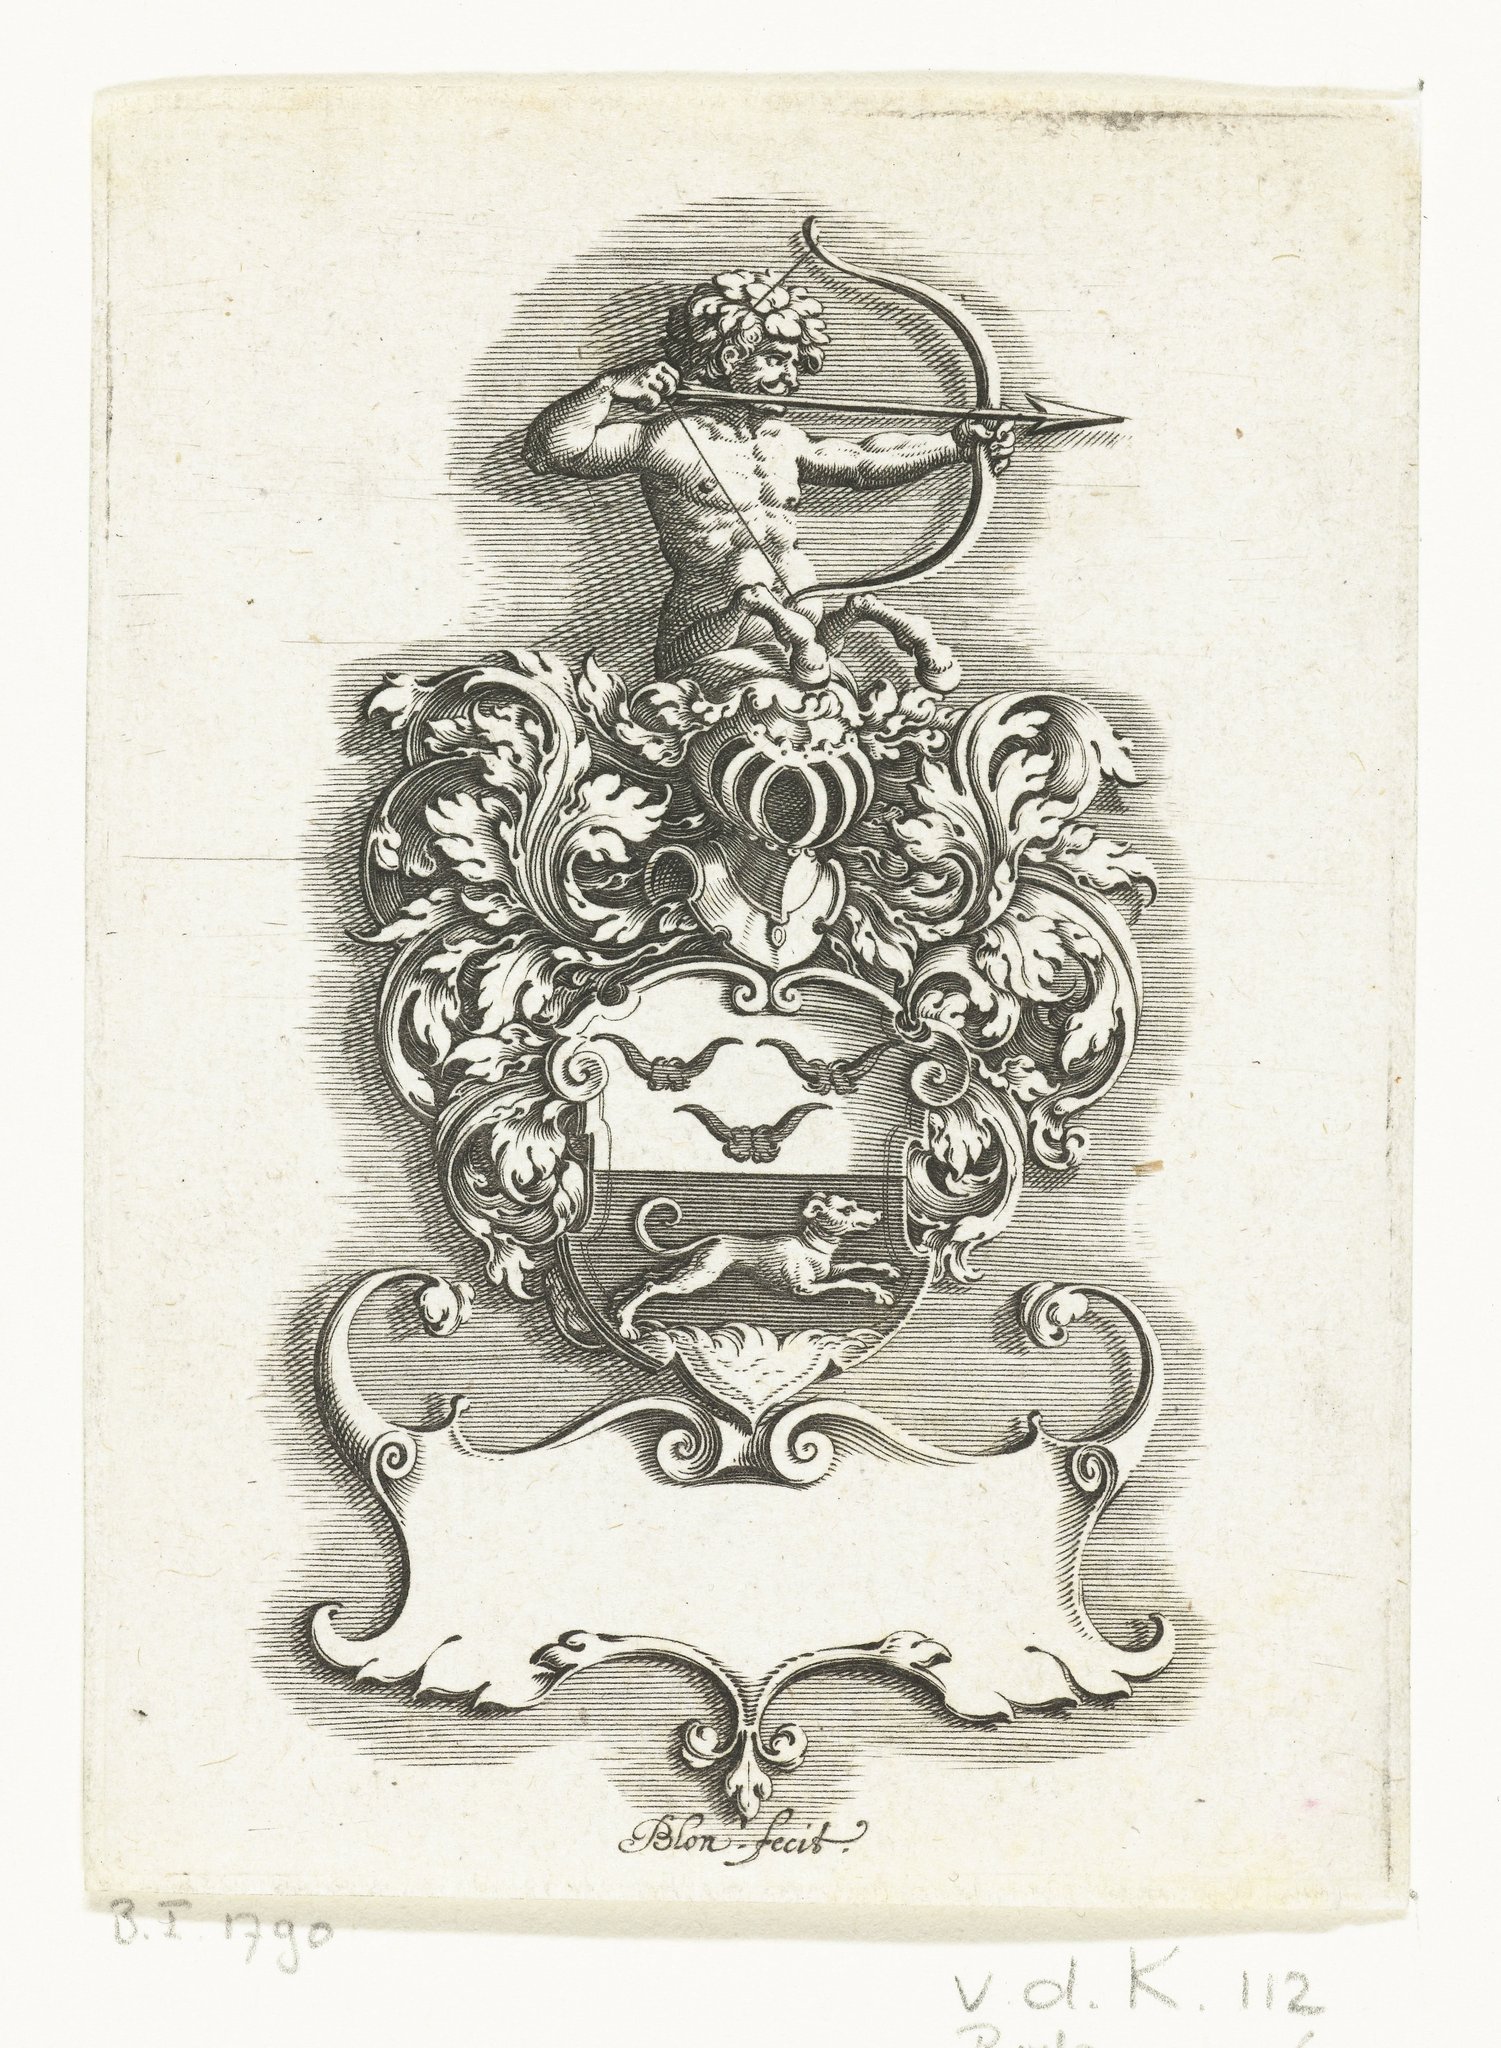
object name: print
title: Wapenschilden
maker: michiel le blon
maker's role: print maker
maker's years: 1587-1656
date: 1611-1625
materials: paper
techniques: engraving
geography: amsterdam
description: Onderaan een lege cartouche. Uit serie van 20 bladen.